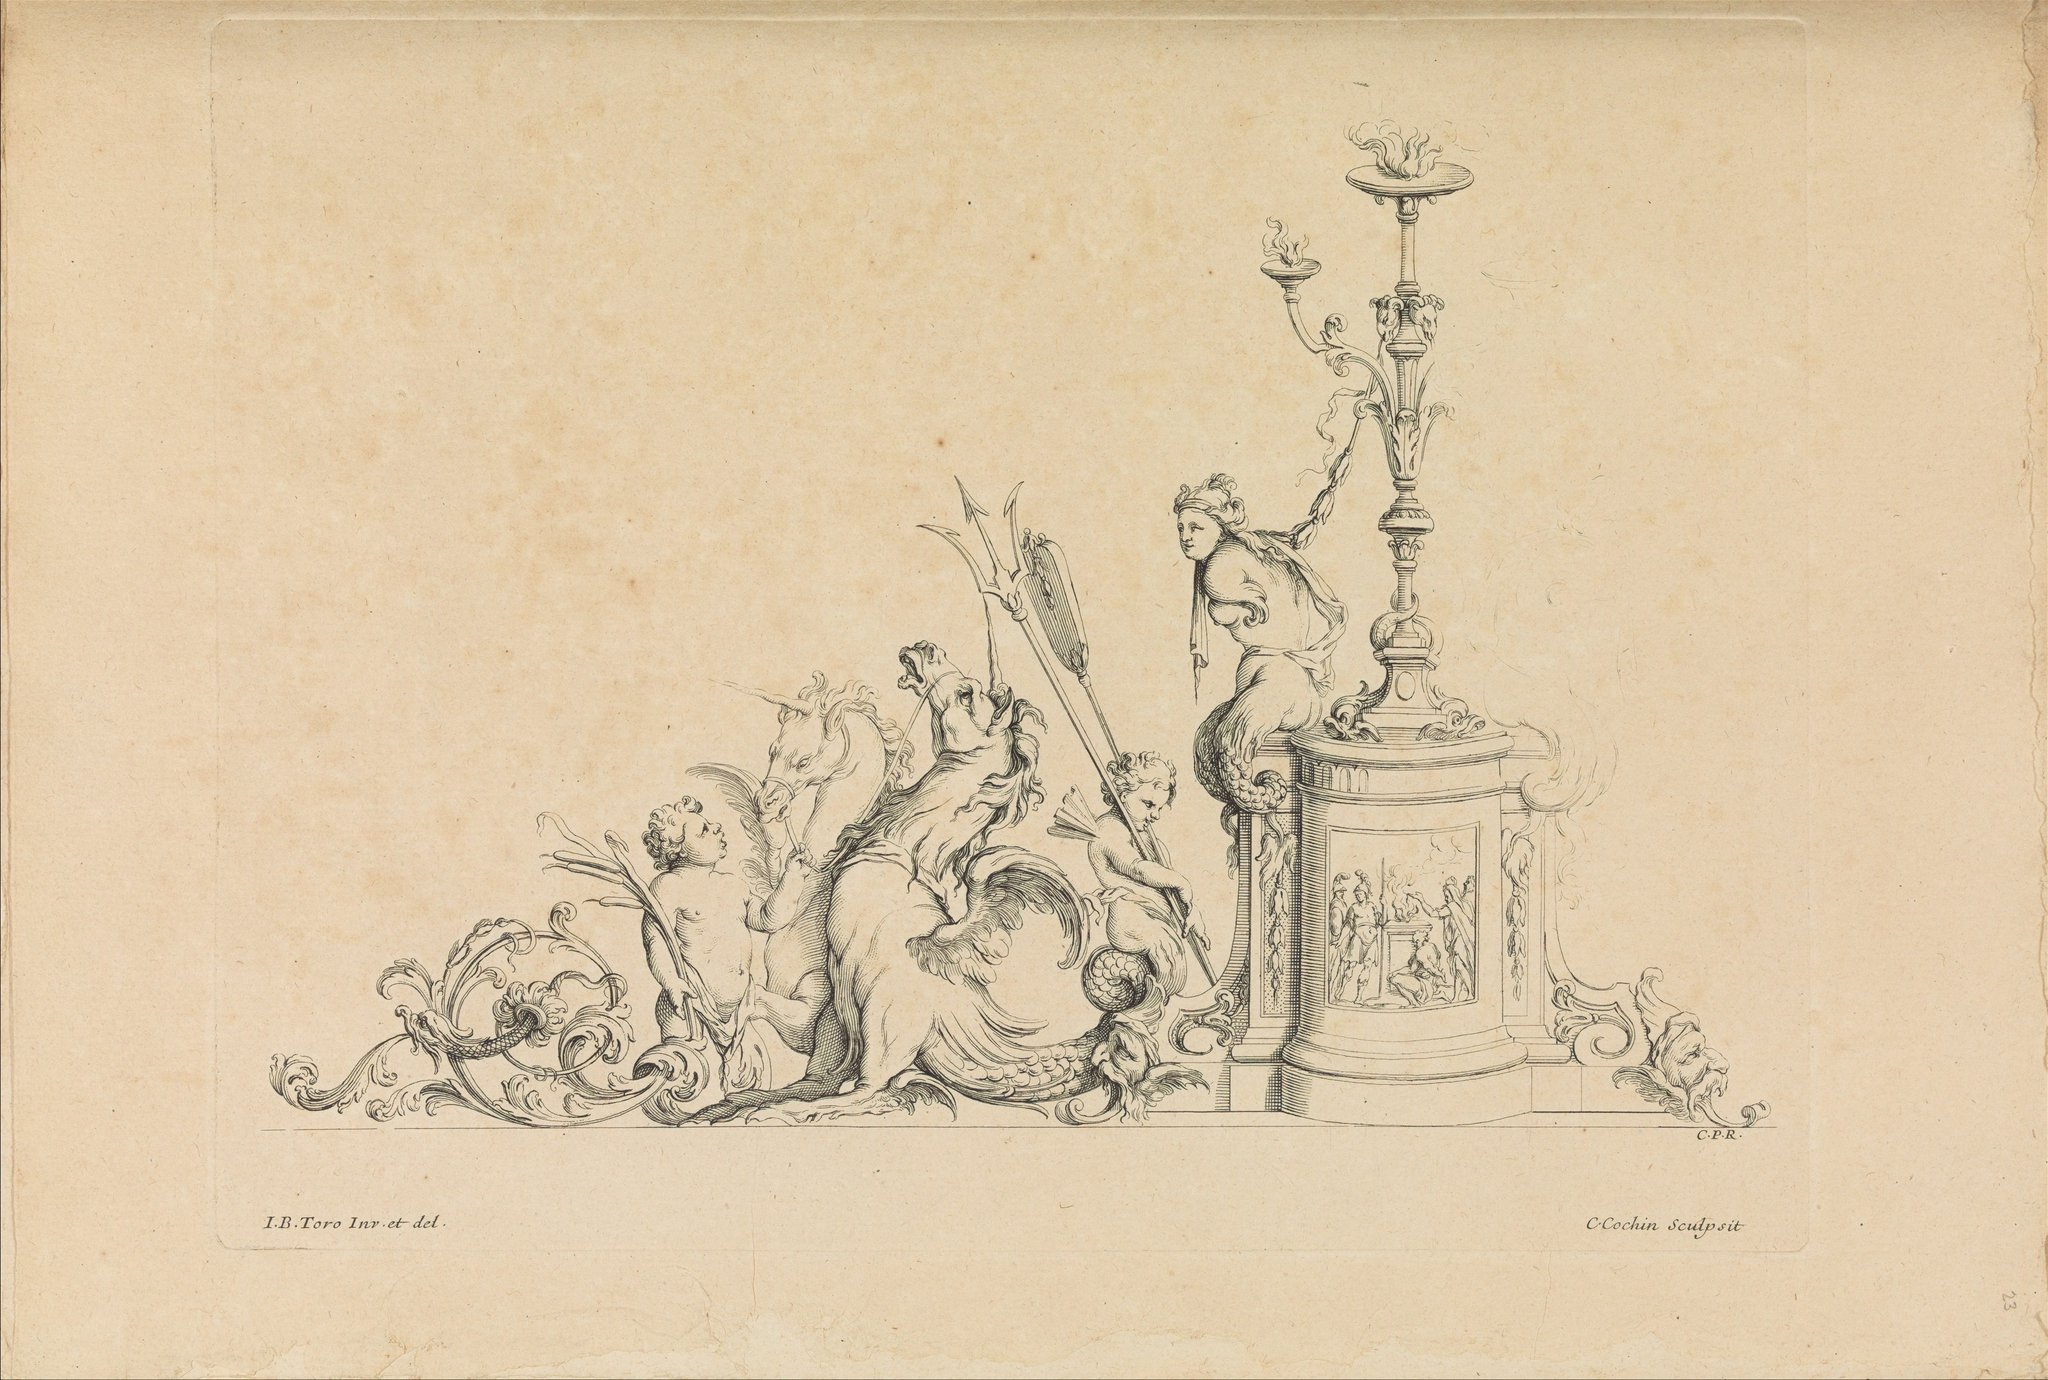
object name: album print ornament architecture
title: Desseins Arabesques a Plusieurs Usages Inventés par J.B. Toro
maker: jean bernard toro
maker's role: designer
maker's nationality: french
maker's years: 1672-1731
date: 1716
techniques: etching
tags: pegasus